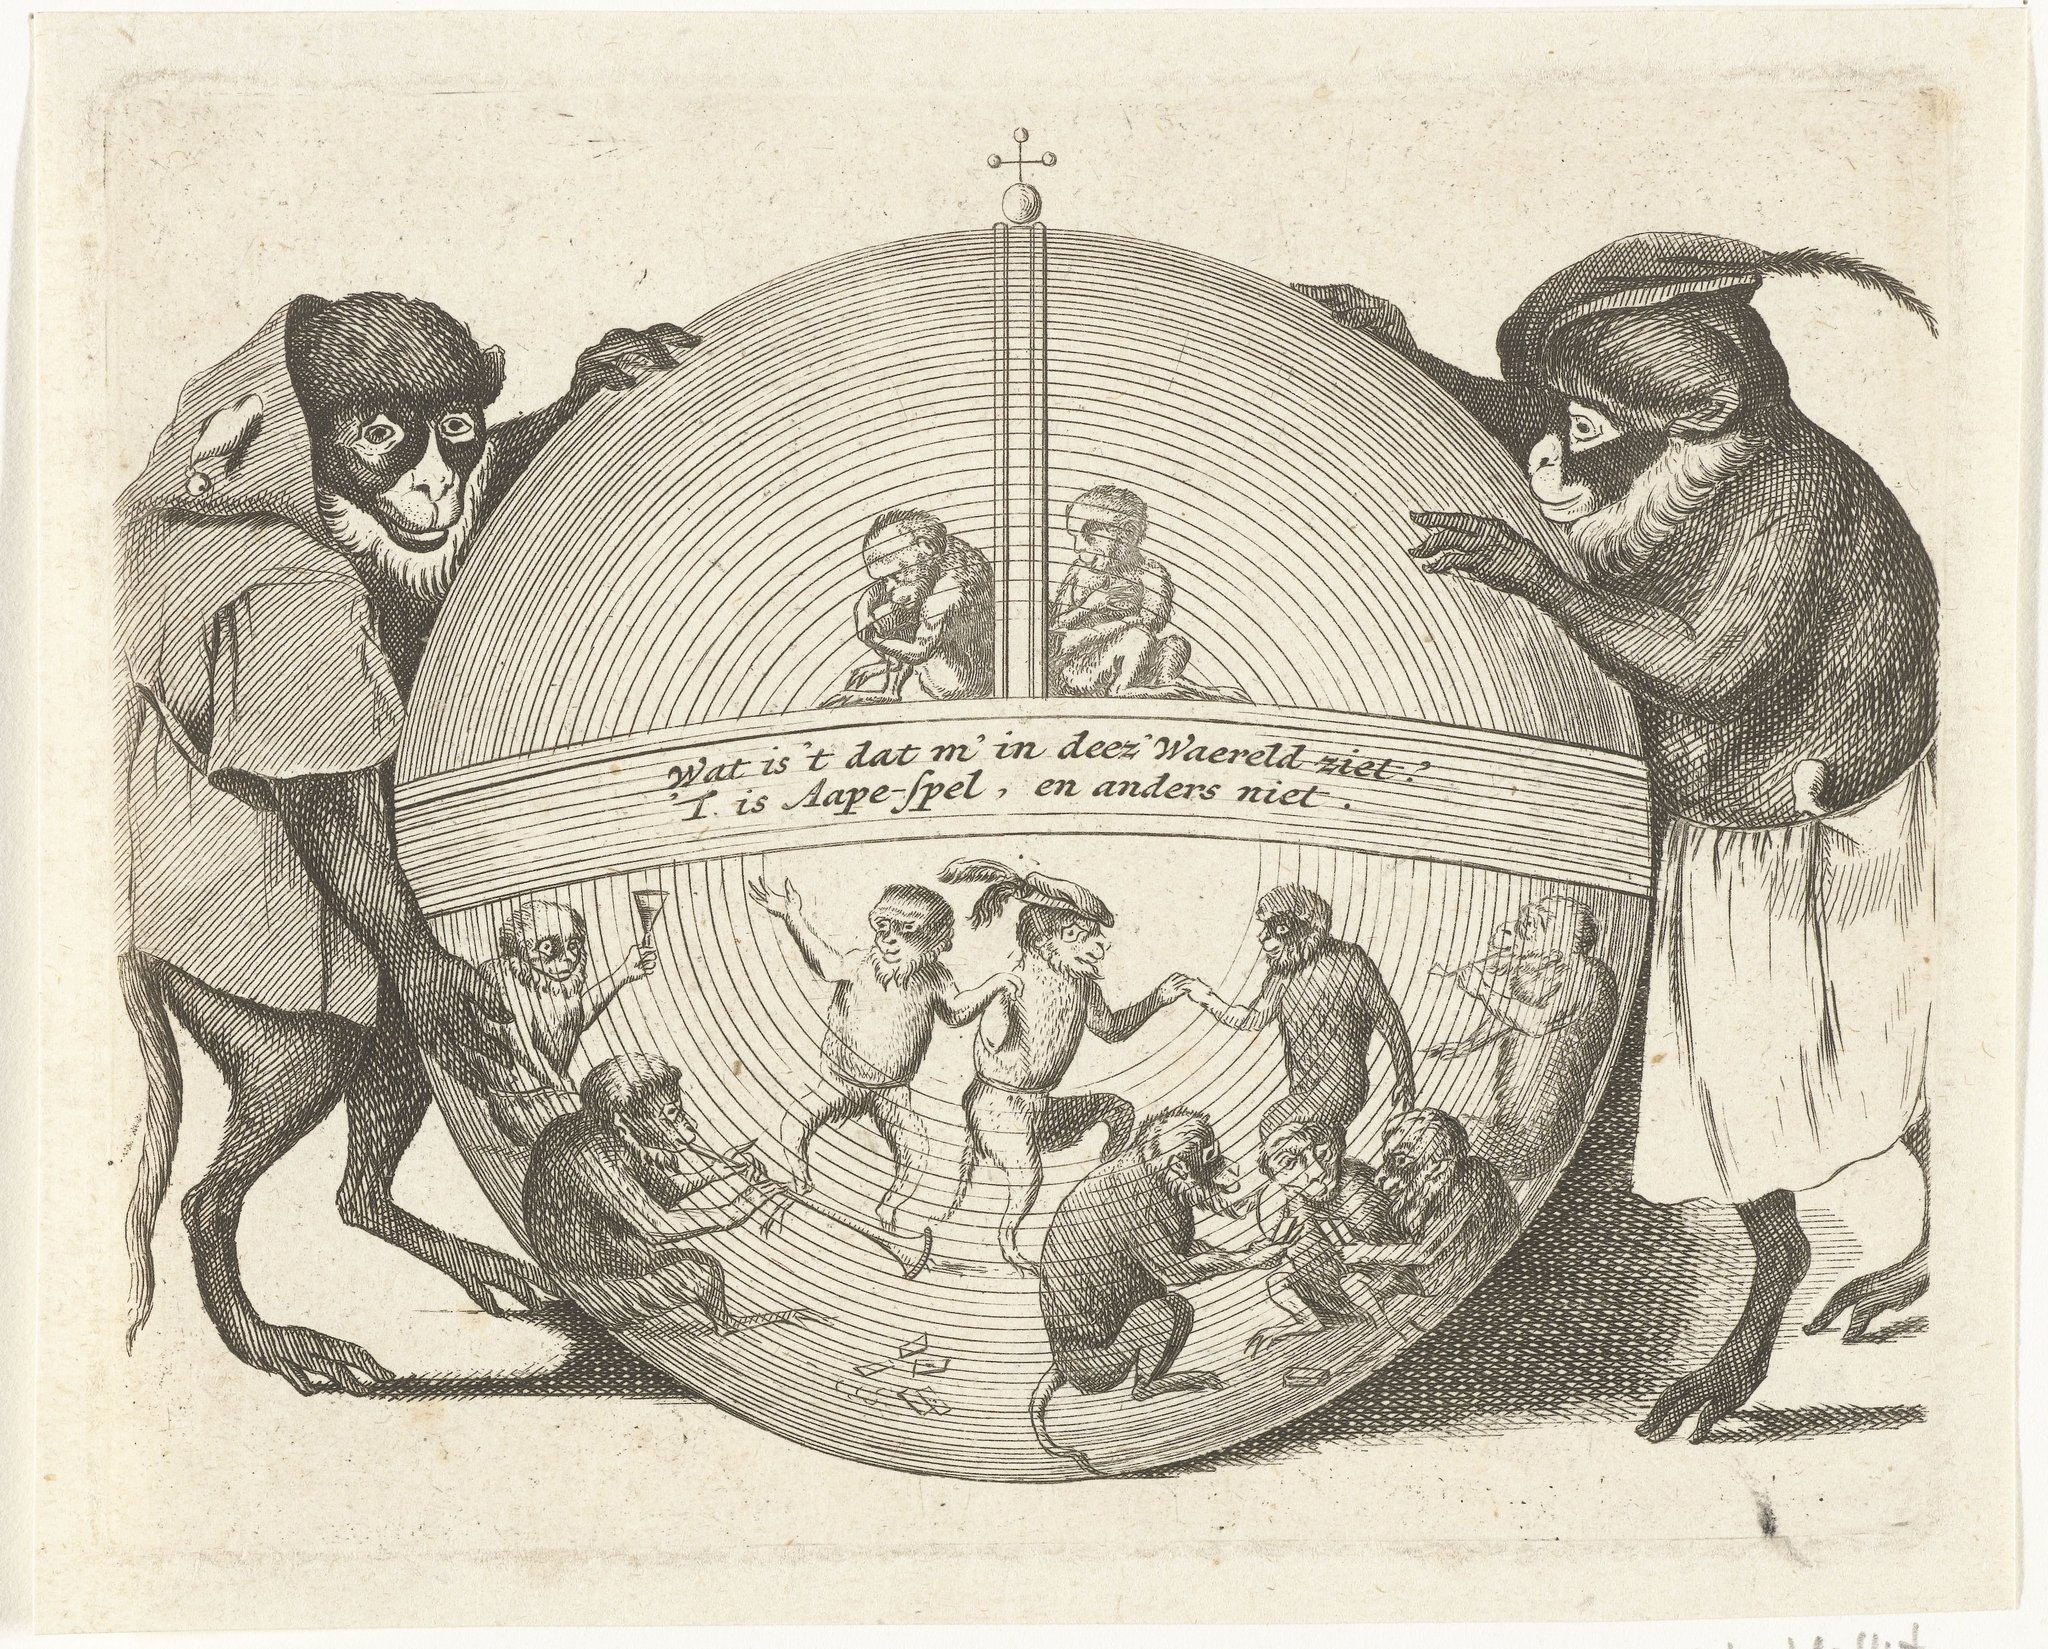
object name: titelprent, frontispice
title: Twee apen houden een wereldbol vast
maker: Anonymous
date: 1635-1724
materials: paper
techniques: engraving, etching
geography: low countries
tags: animals acting as human beings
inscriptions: collector's mark: Lugt 2228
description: Titelprent uit een serie van zes prenten en een titelprent waarin verschillende menselijke bezigheden door apen voorgesteld worden. Kopieën naar prenten van Quirin Boel, met een toegevoegd vers in het Nederlands onder elke voorstelling.